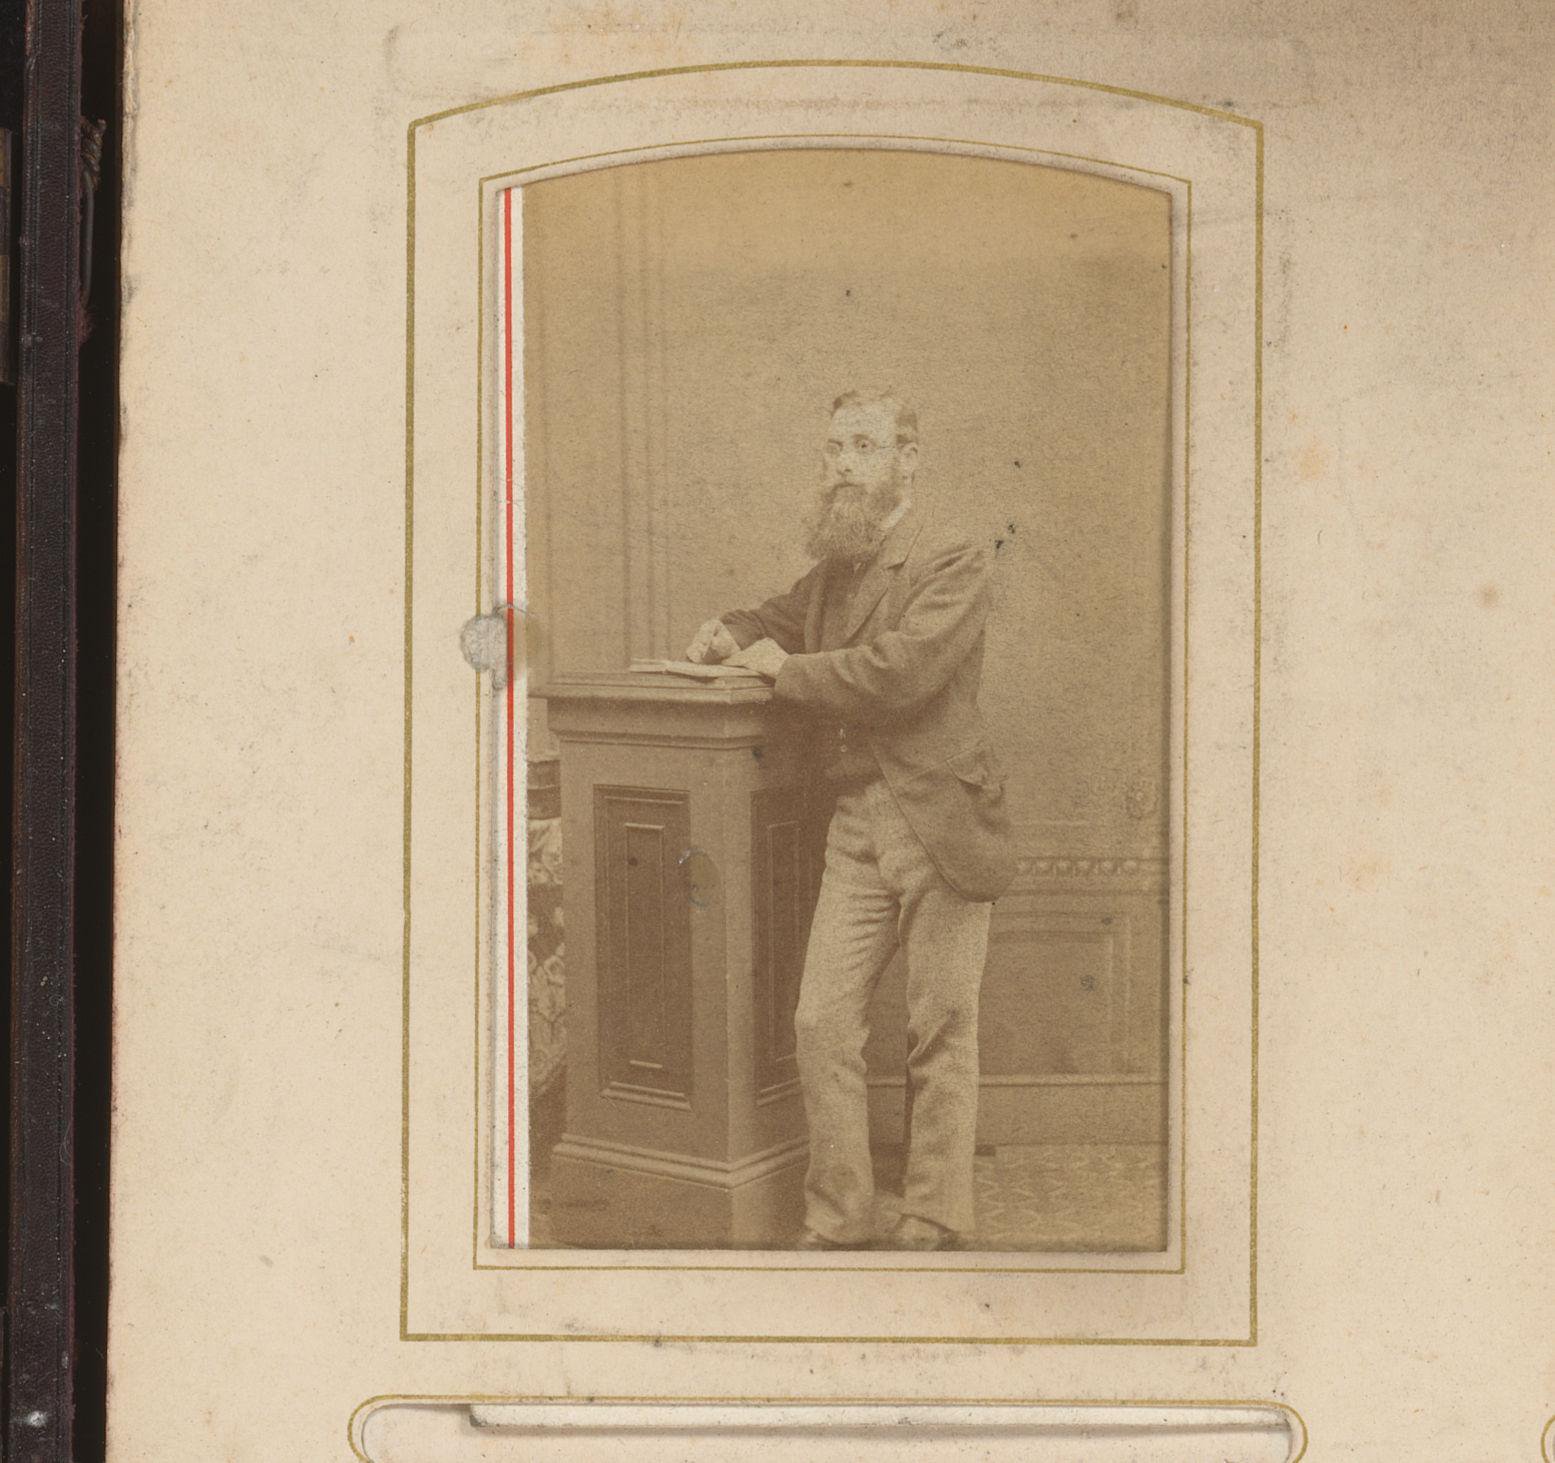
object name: photograph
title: Portret van een staande schrijvende man met bril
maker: Anonymous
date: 1860-1900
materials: cardboard, photographic support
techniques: albumen print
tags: eyeglasses, spectacles, standing figure, historical persons